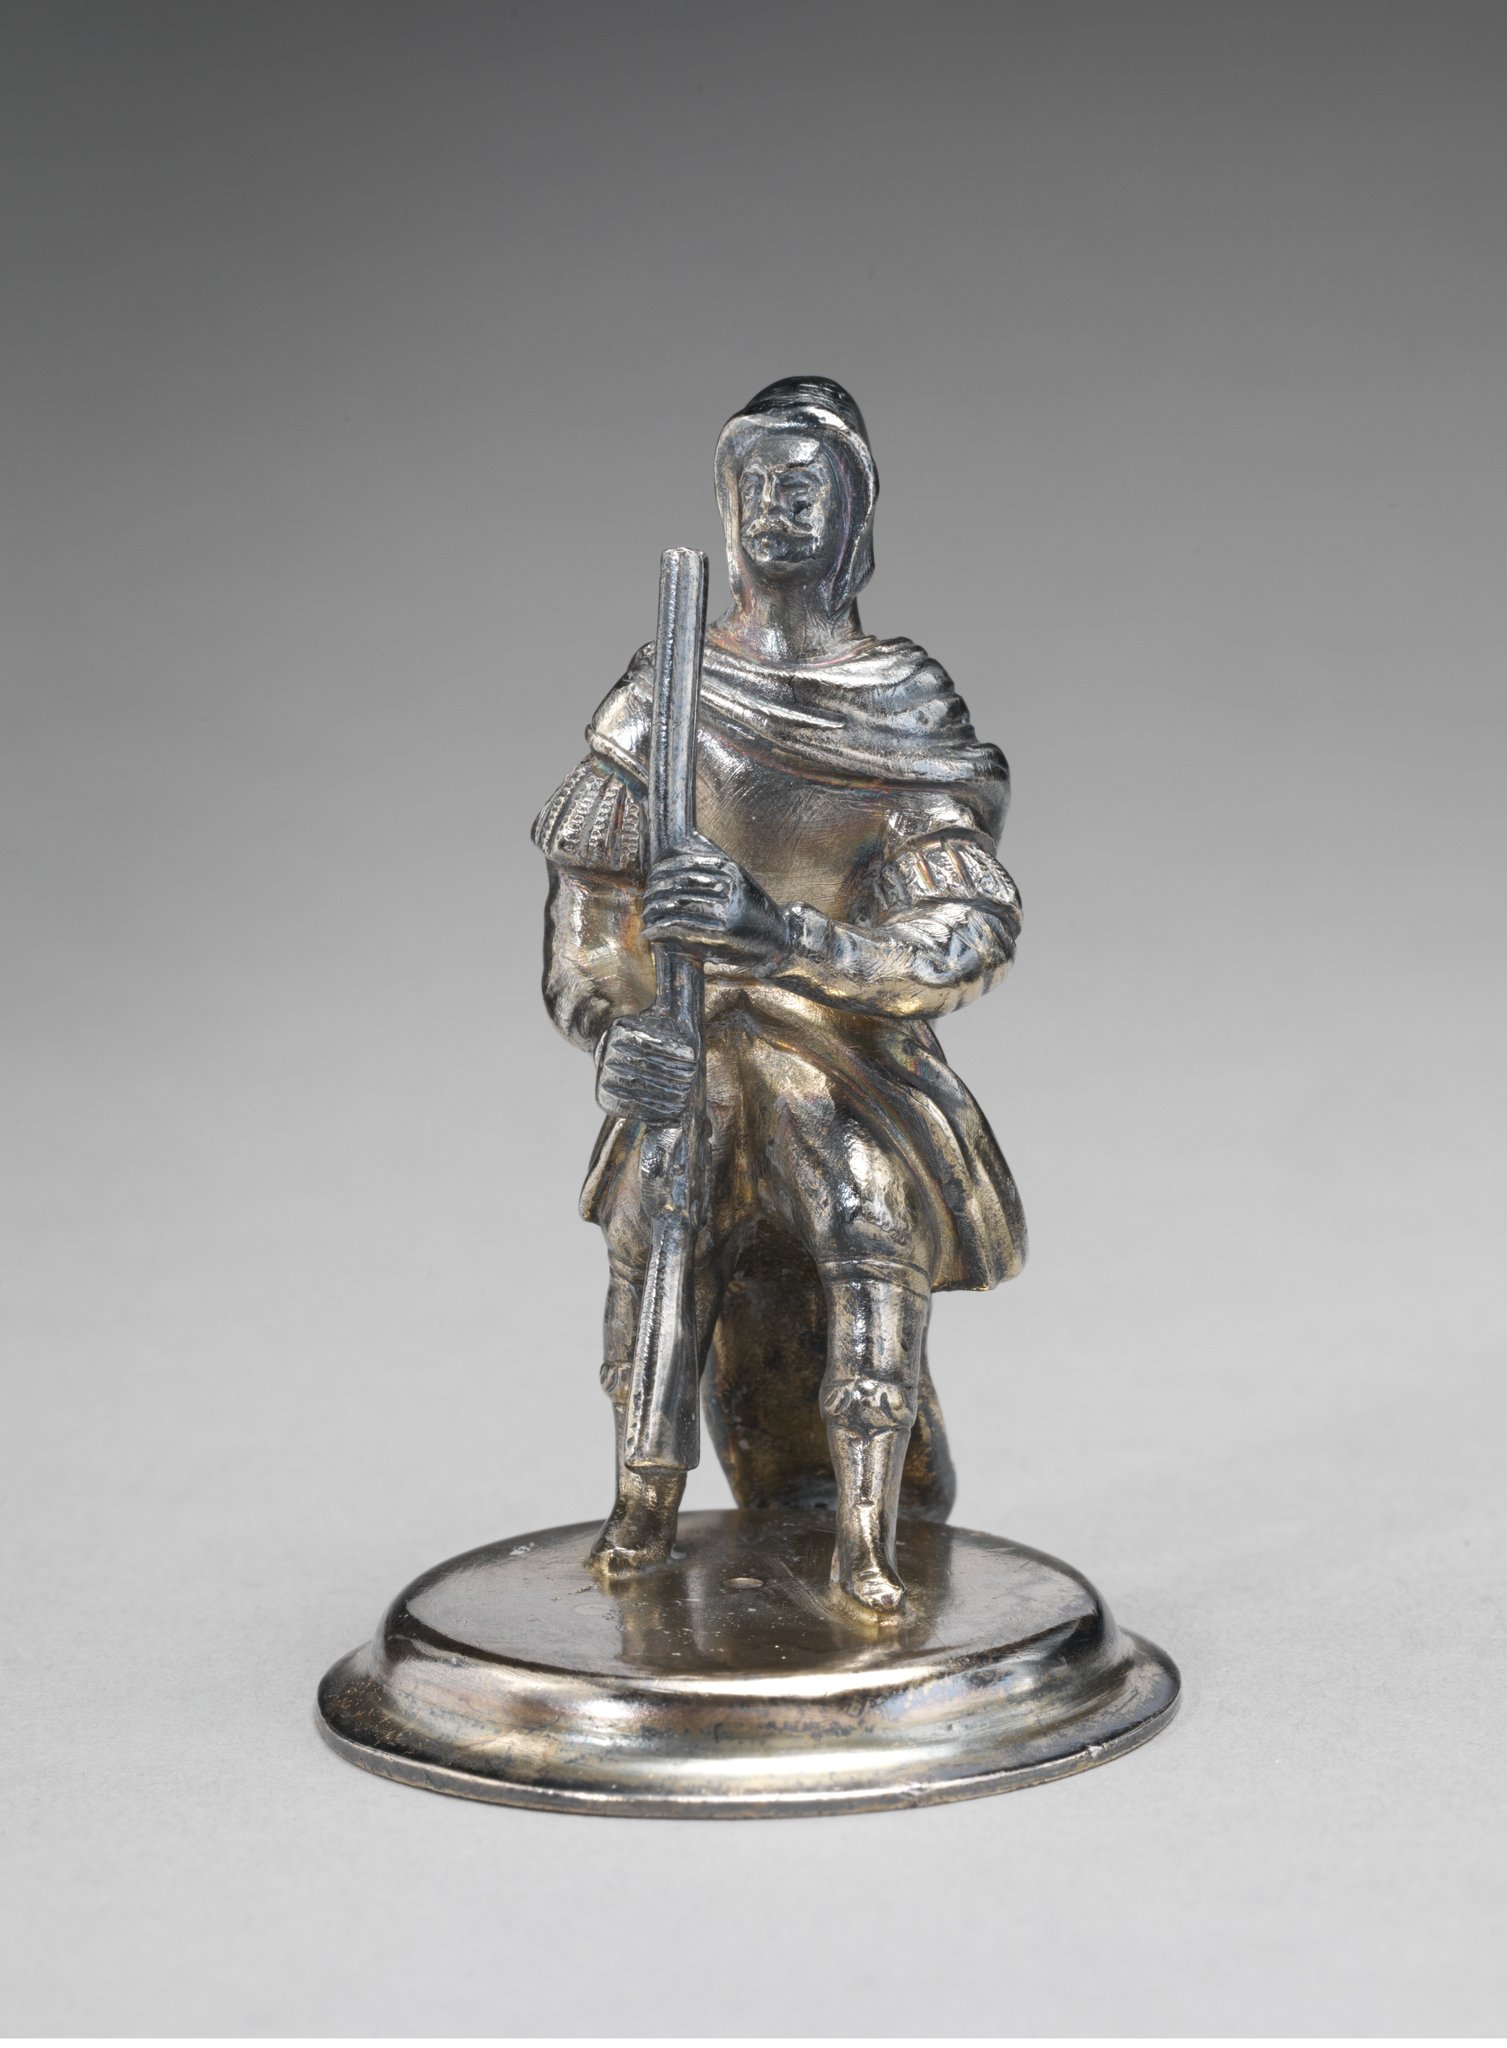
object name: chessman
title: Chessman (Pawn)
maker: elkington & co.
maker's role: manufacturer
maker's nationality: british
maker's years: 1829-1963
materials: silver gilt